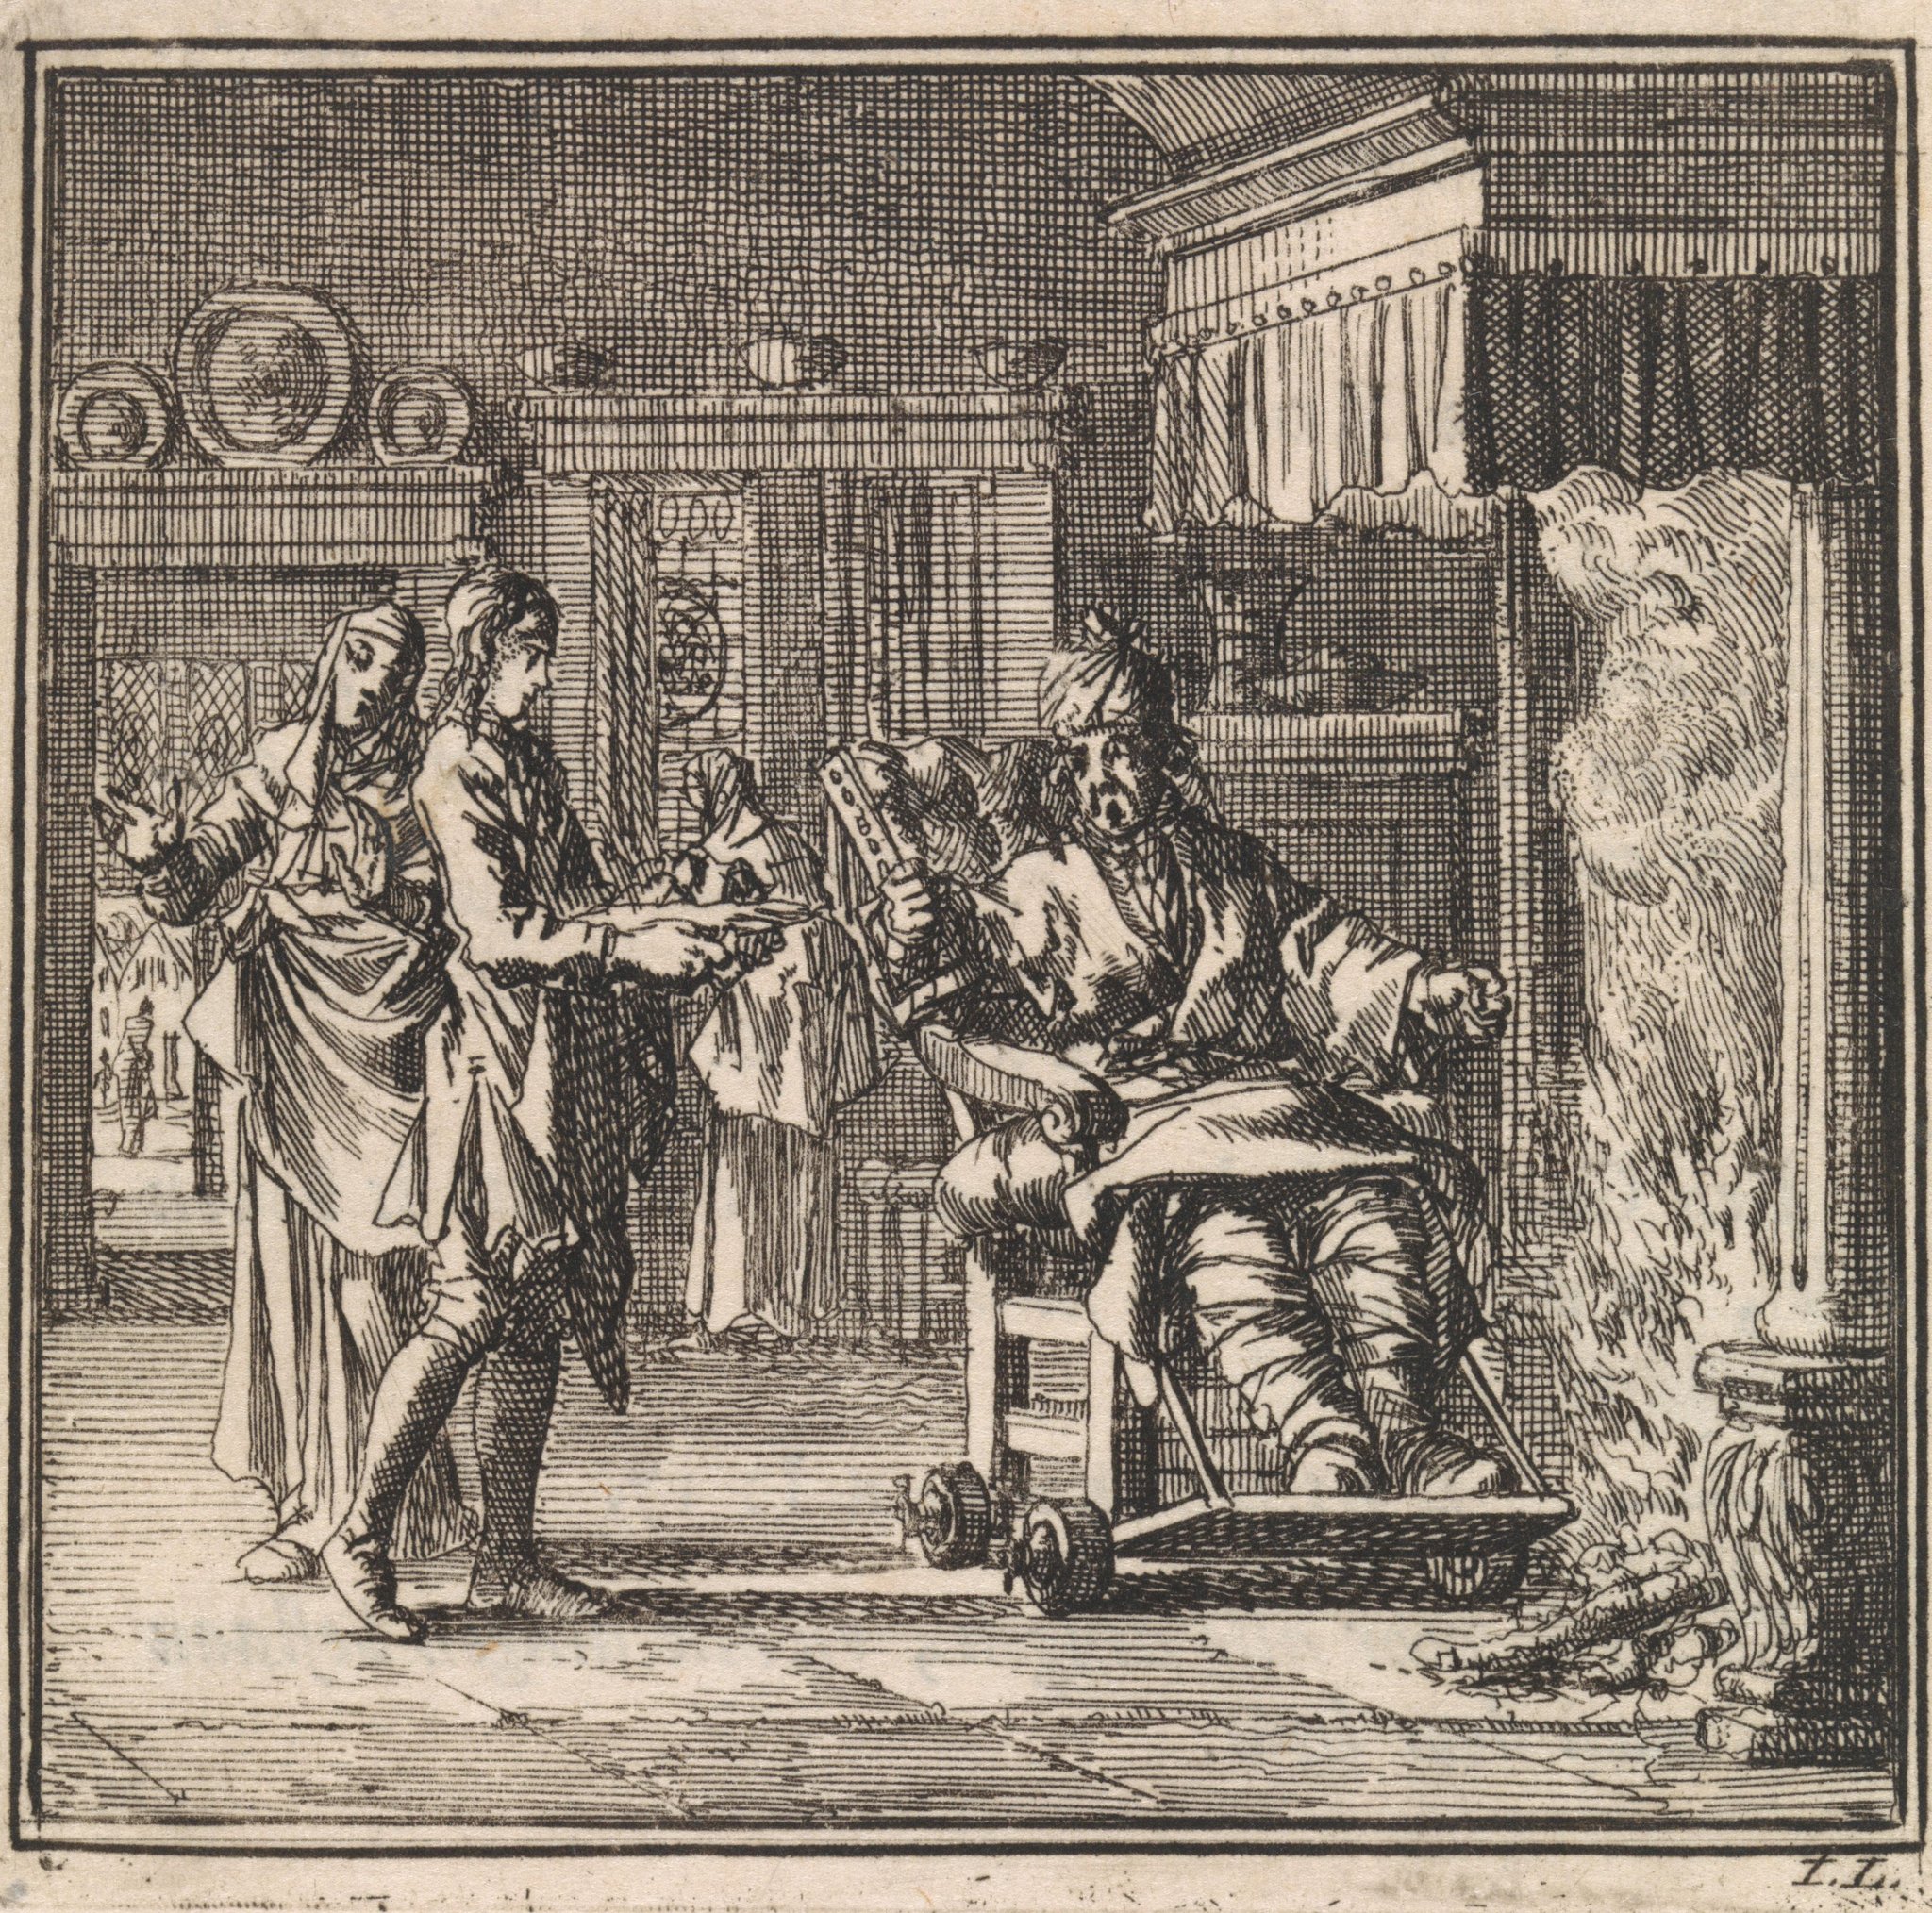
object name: book illustration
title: Man met voetjicht krijgt eten geserveerd voor de openhaard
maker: jan luyken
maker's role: draughtsman, print maker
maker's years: 1649-1712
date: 1711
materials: paper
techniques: etching, letterpress printing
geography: amsterdam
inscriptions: collector's mark: Lugt 2228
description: Illustratie voor: Luyken, Jan. De Bykorf des Gemoeds. Amsterdam: Pieter Arentsz. II (wed.) en Cornelis van der Sys, 1711, p. 174.